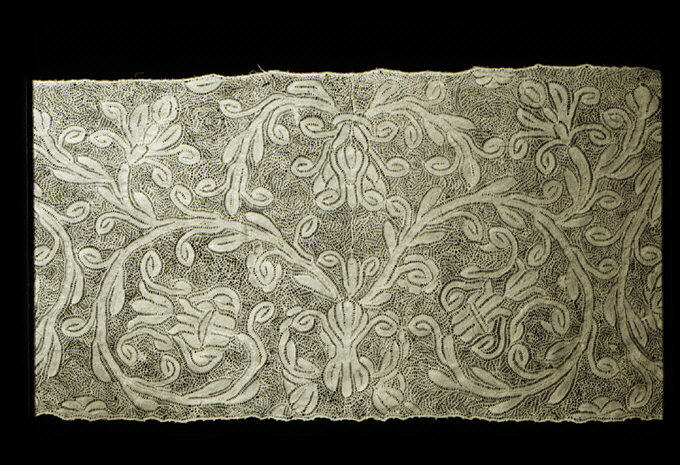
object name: fragment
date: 1701-1800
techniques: lace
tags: flowers,leaves